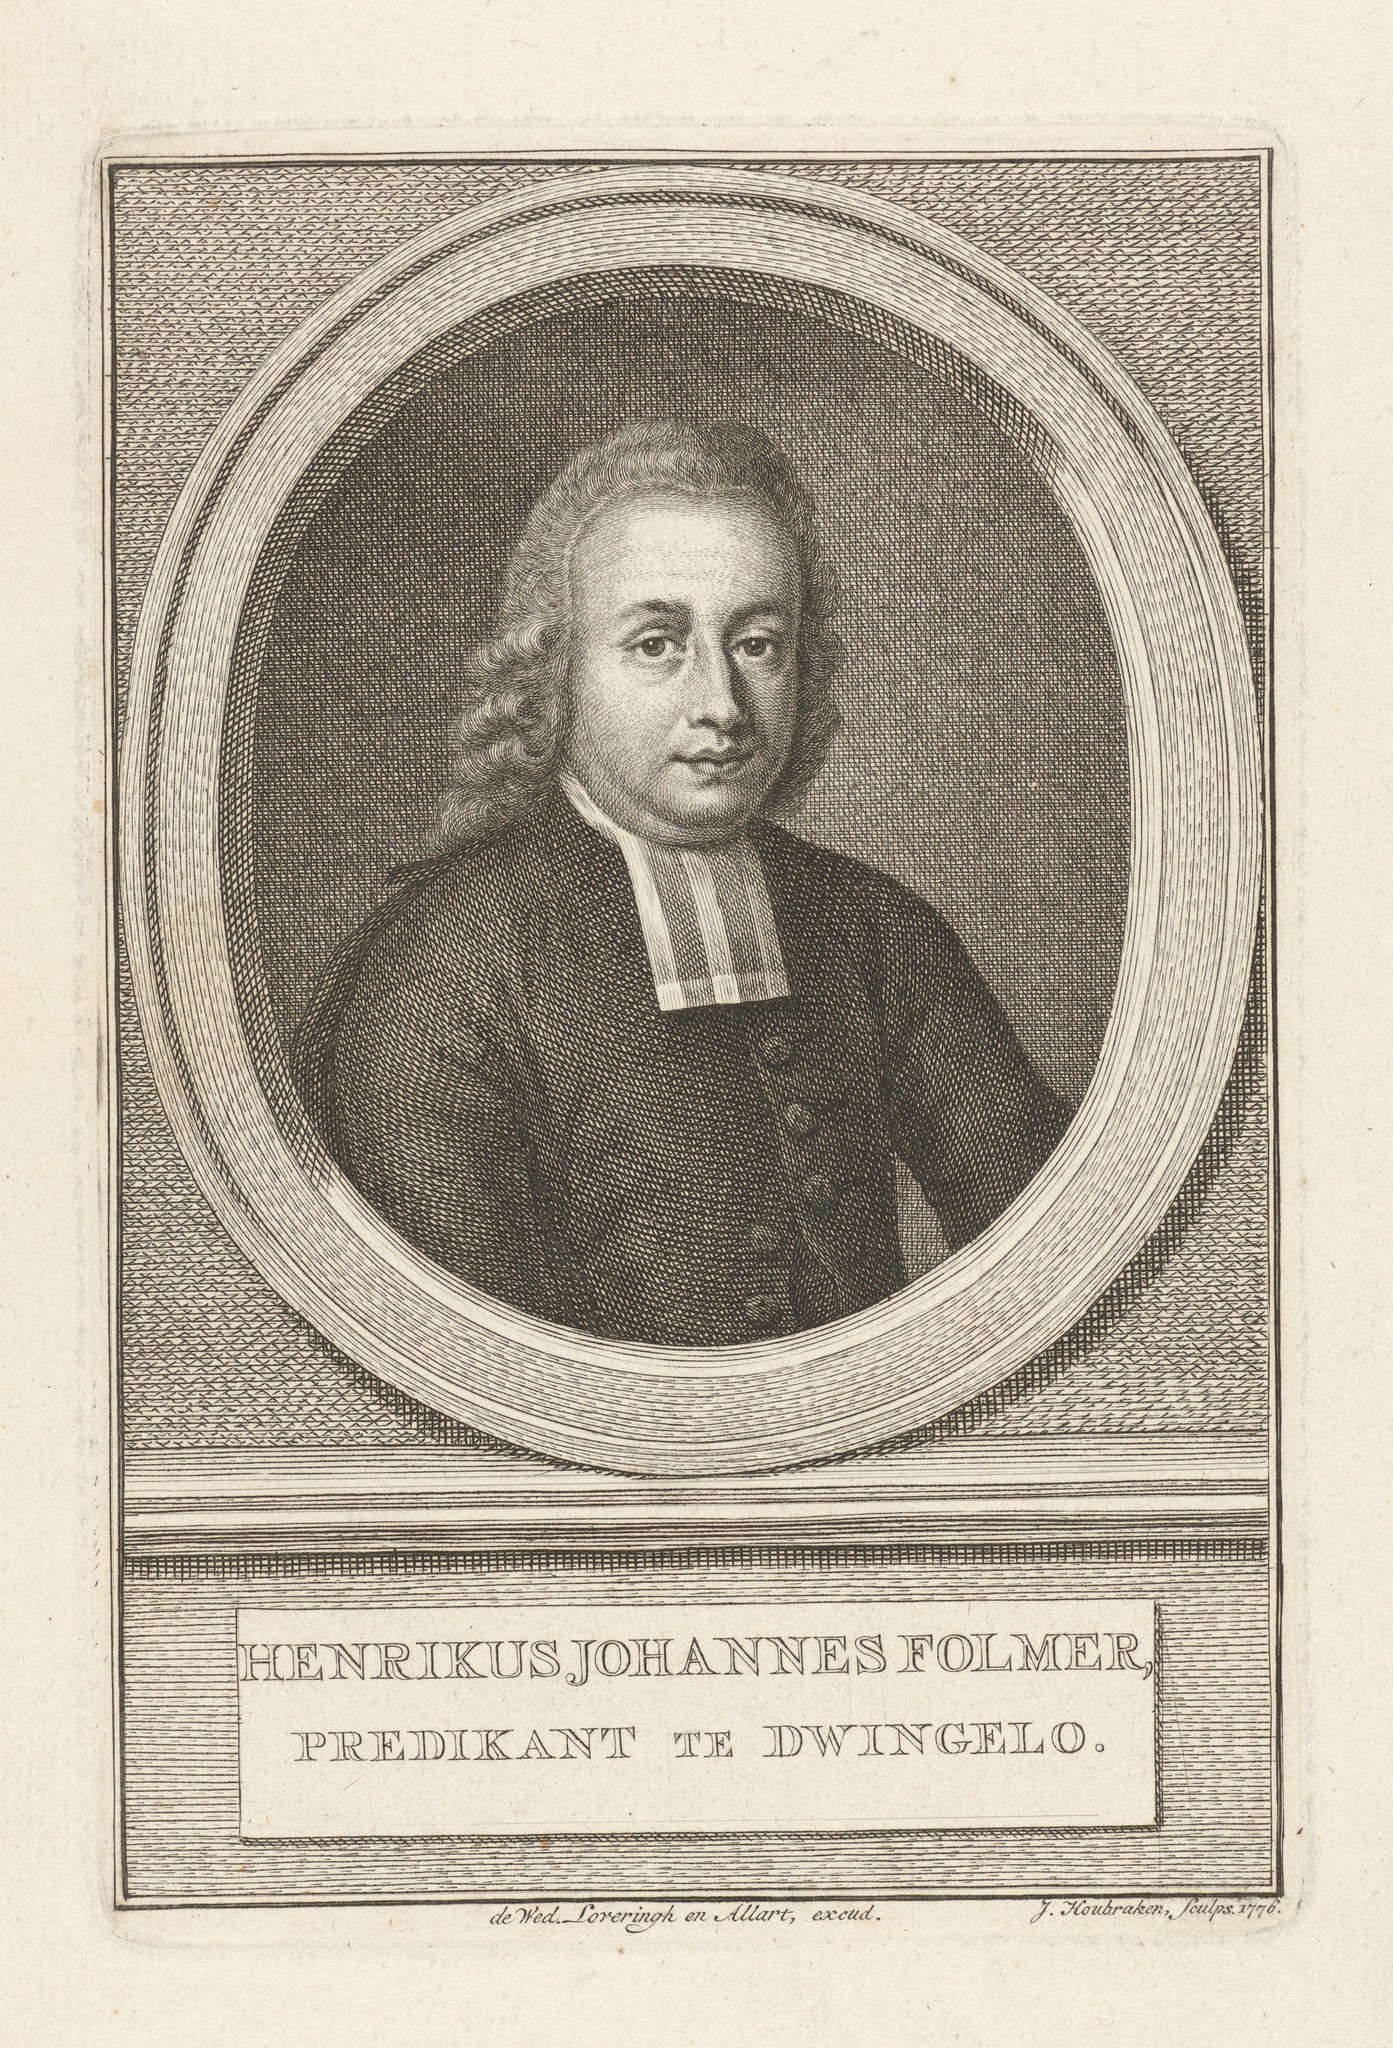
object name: print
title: Portret van Henricus Johannes Folmer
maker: jacob houbraken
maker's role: draughtsman, print maker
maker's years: 1698-1780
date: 1776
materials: paper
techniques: engraving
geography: amsterdam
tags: predikant, henricus johannes folmer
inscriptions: collector's mark: Lugt 2228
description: Prent volgens Ver Huell ook gebruikt in: Josua van Iperen, Kerkelyke historie van het psalm-gezang der christenen (...) en inzonderheid van onze verbeterde Nederduitsche psalmberyminge. Amsterdam: wed. Loveringh en Allart, 1777. Deel 2: J. Allart, 1778.